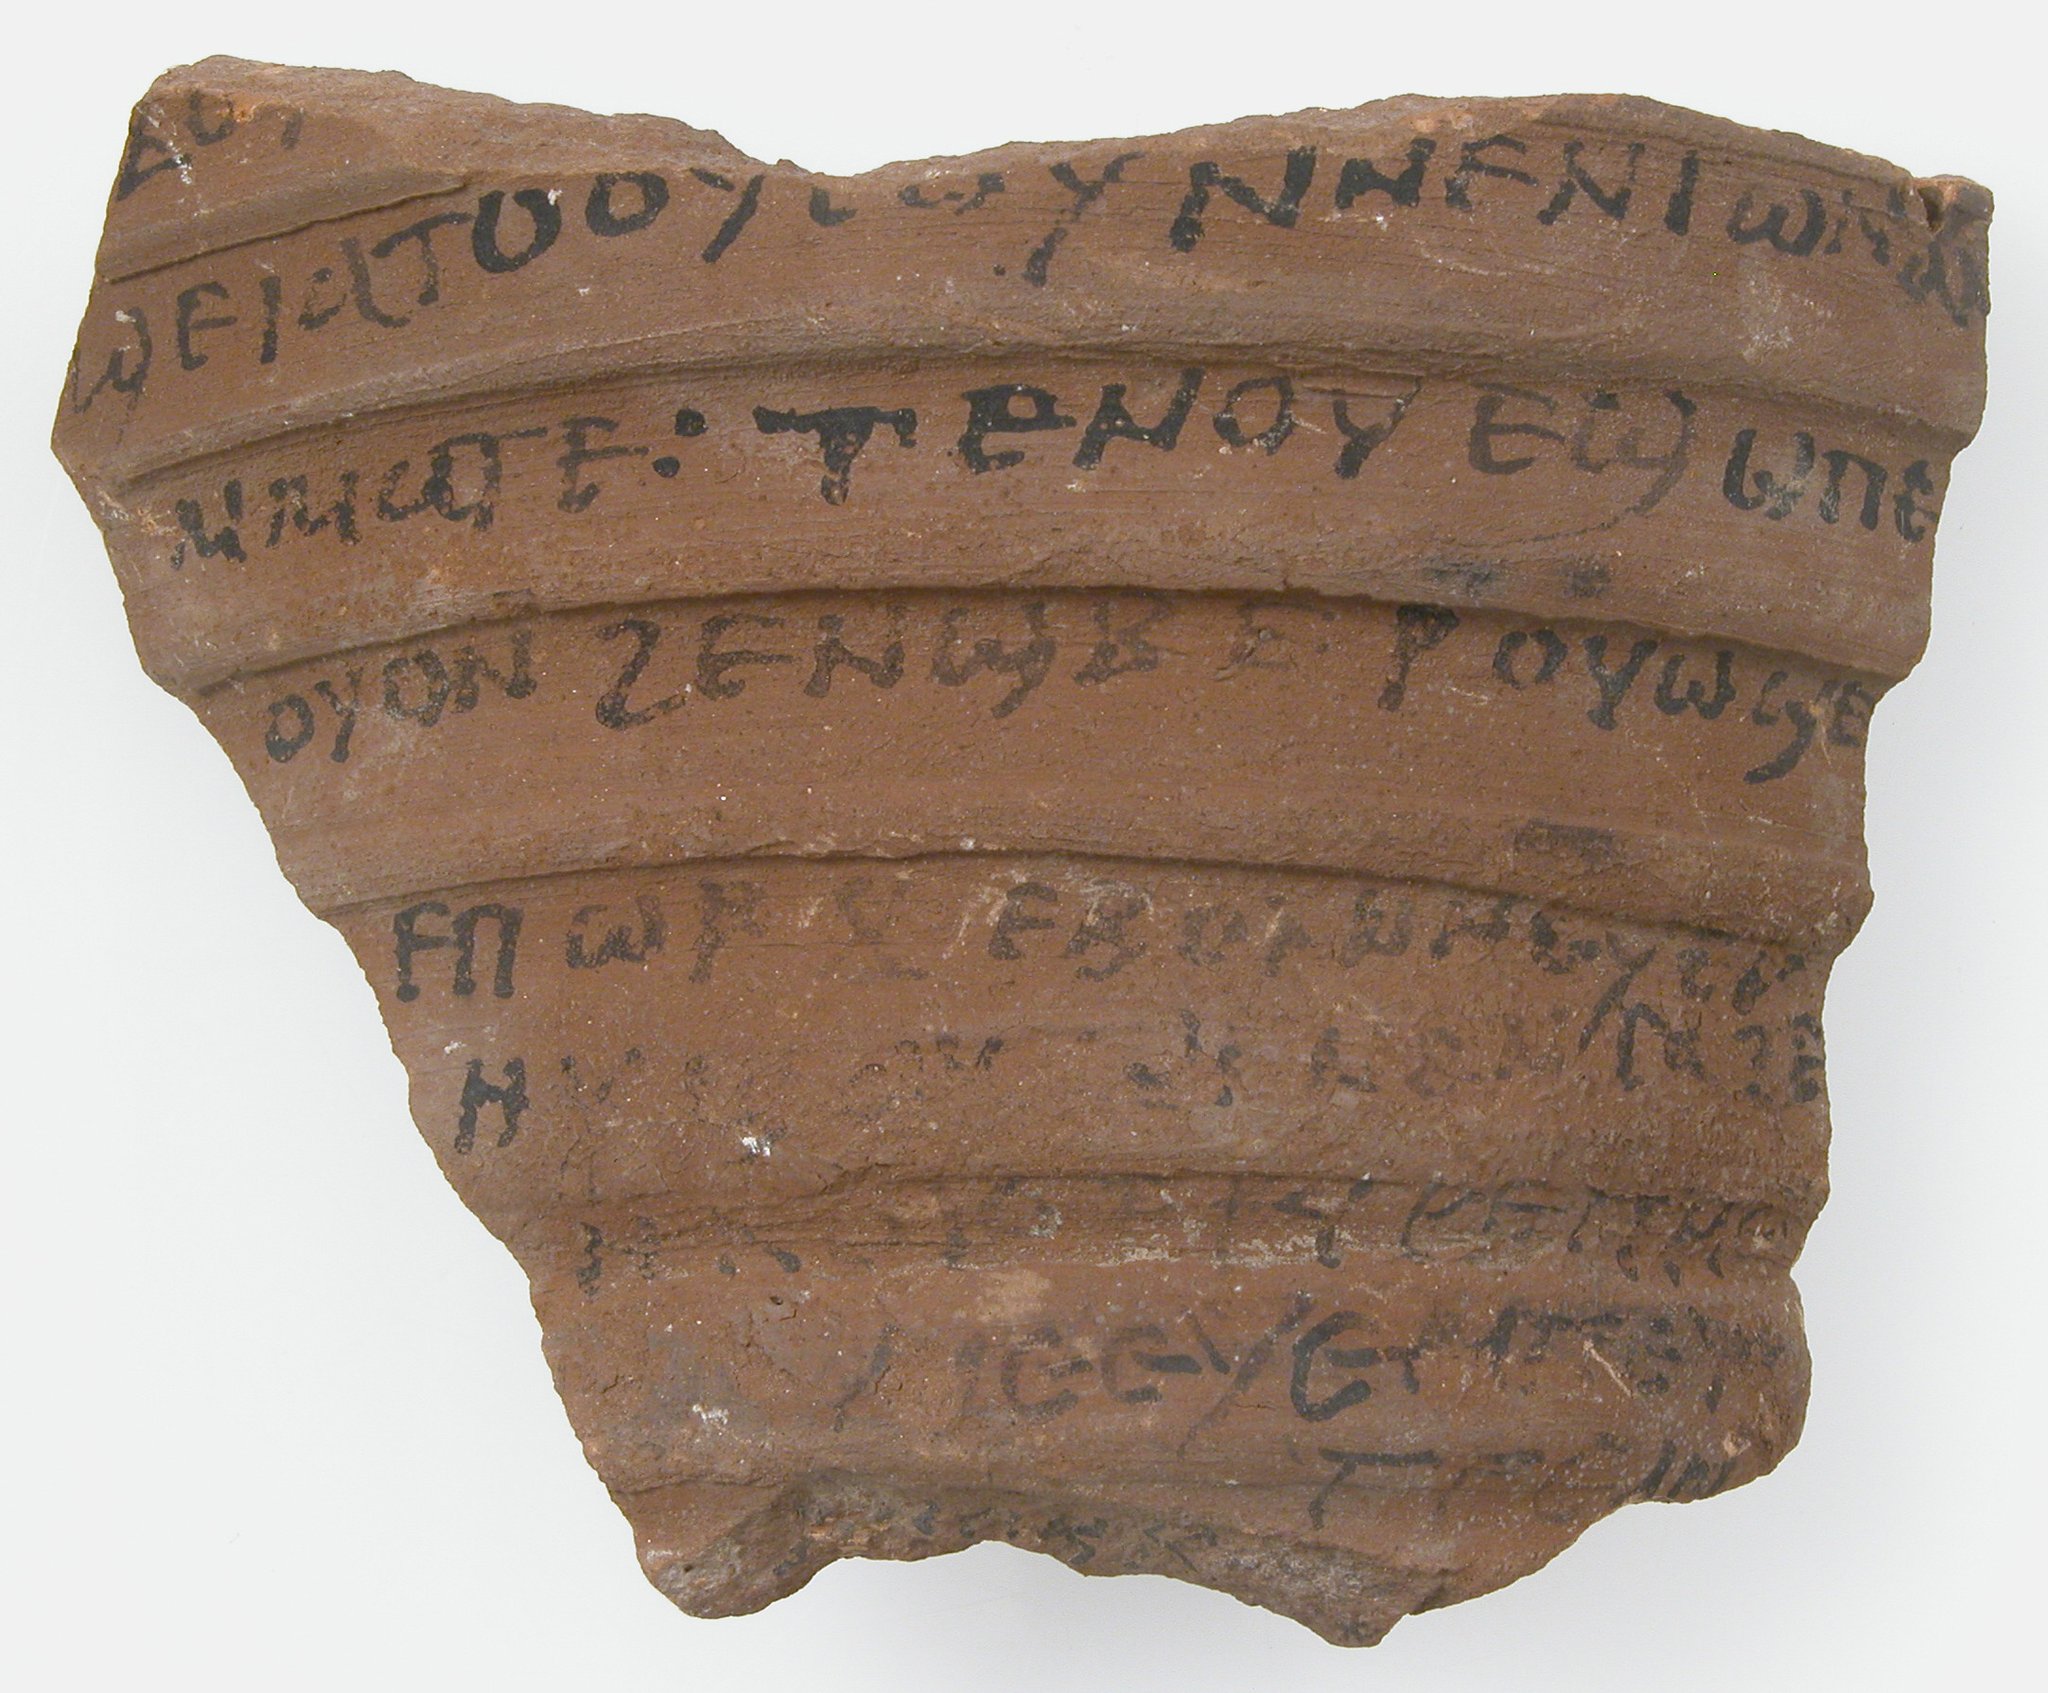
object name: ostrakon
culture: coptic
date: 600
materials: ink, pottery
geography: egypt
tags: coptic,documents